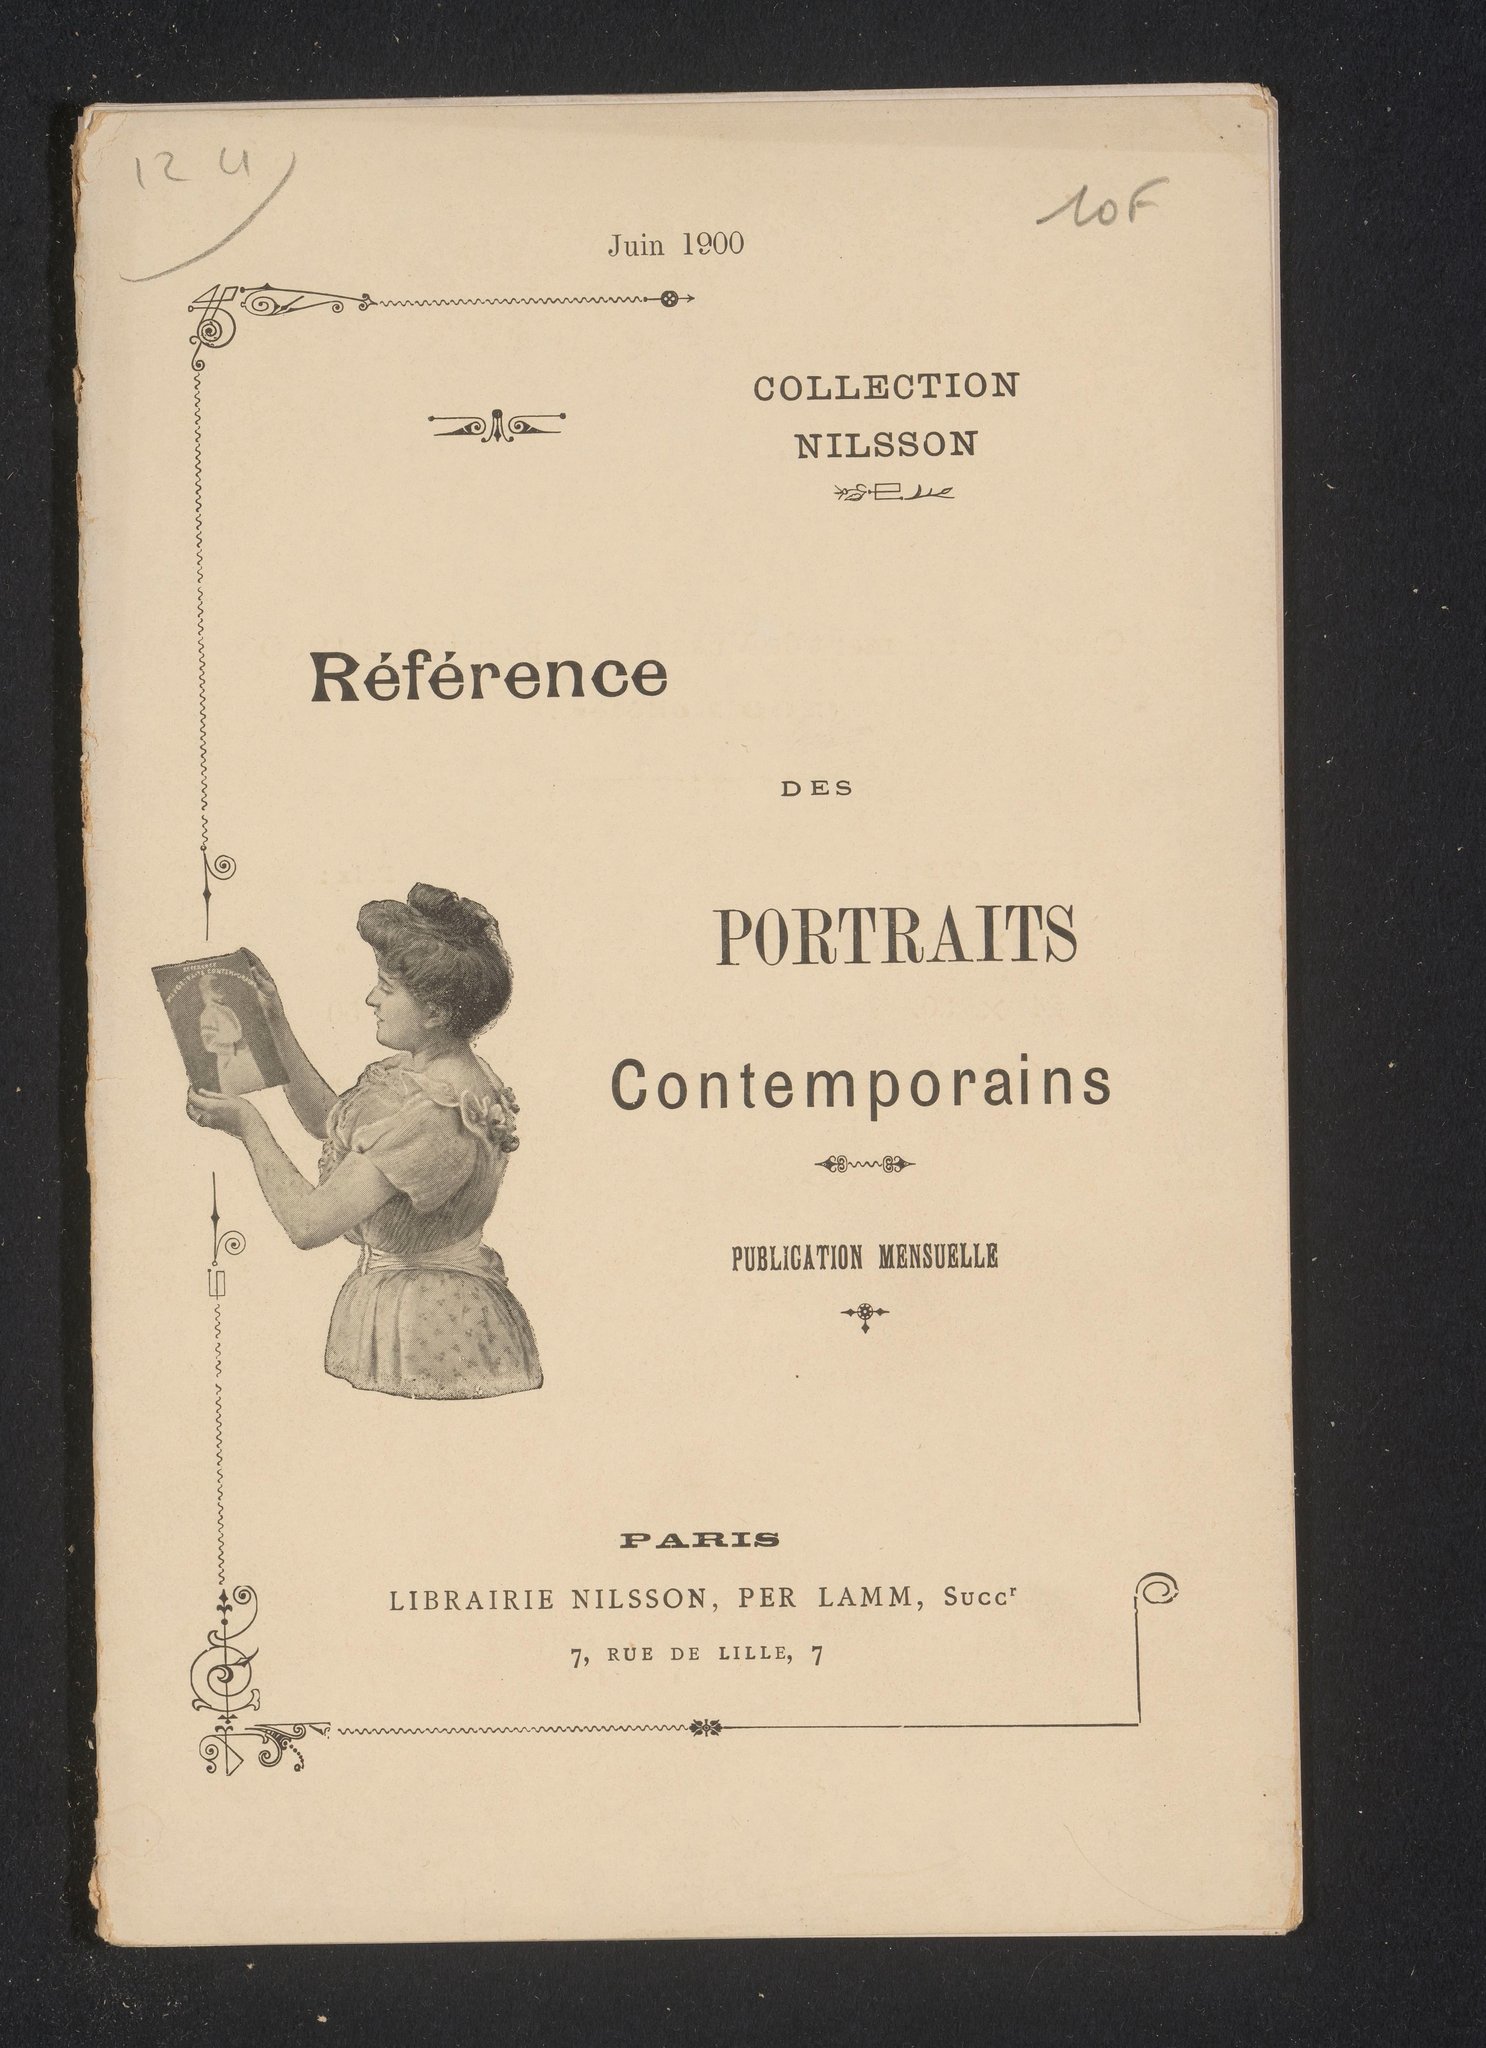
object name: magazine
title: Référence des portraits contemporains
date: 1900-1906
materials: paper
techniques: photograph, printing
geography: paris